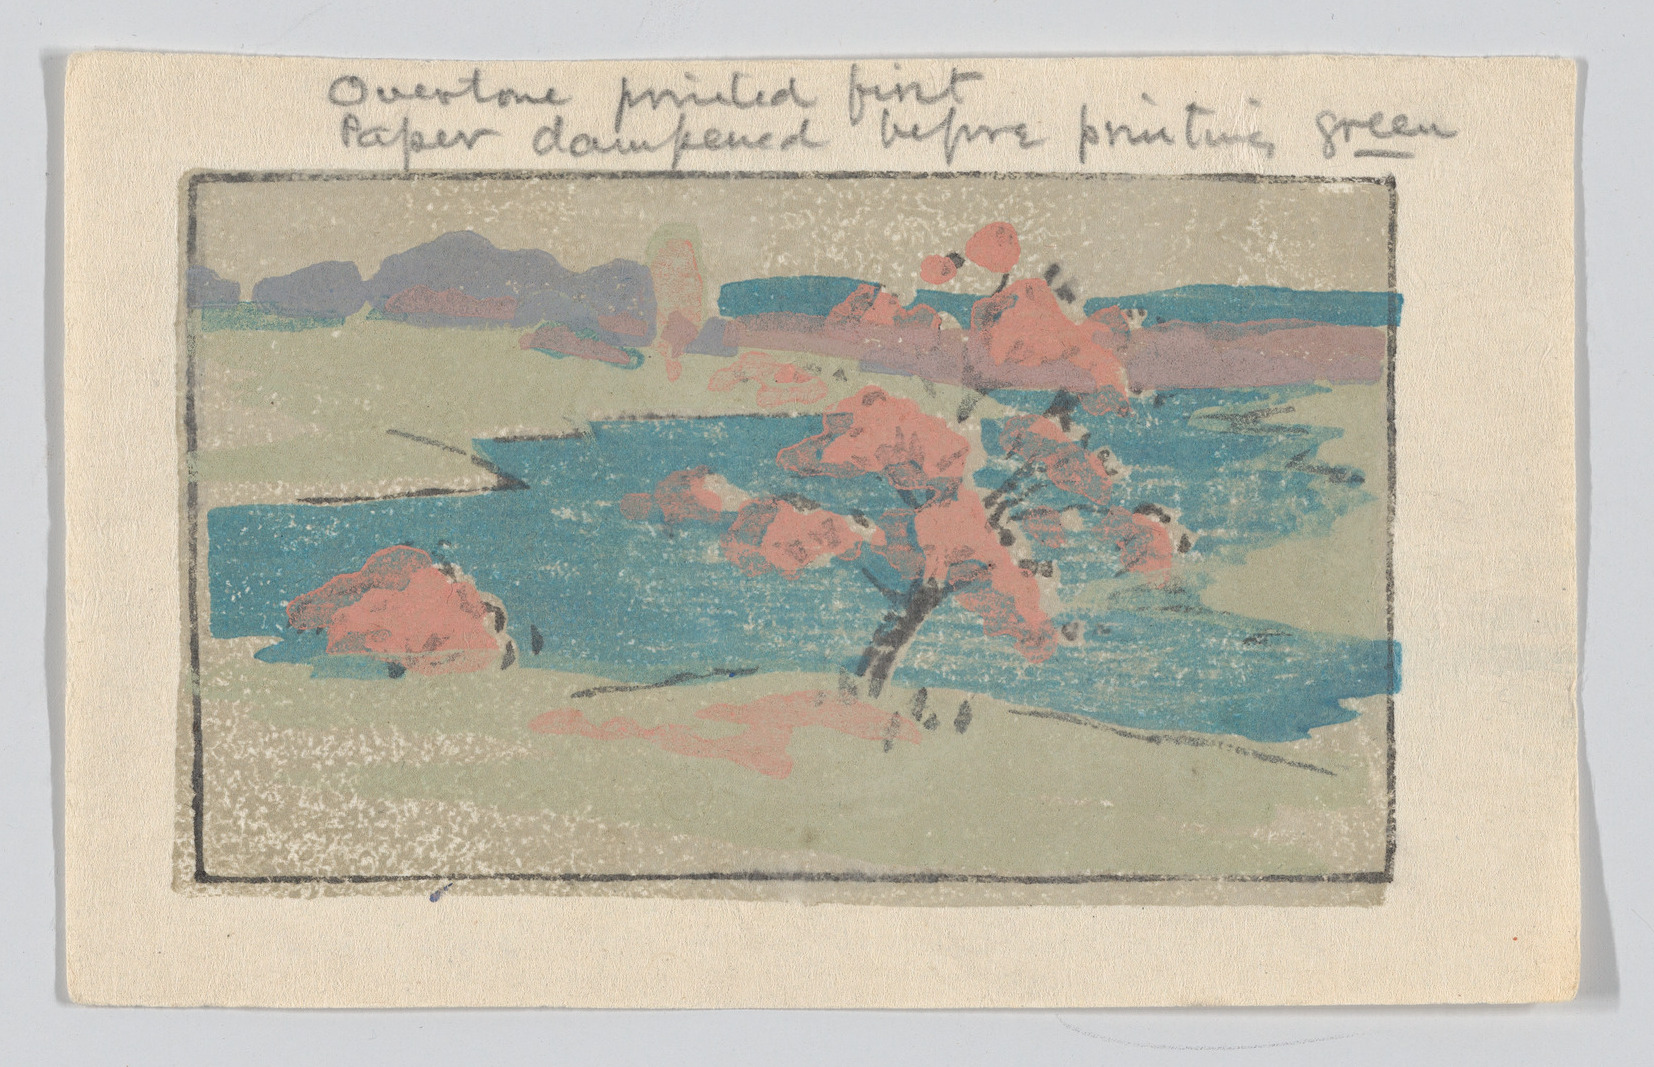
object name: woodcut, print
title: Nabby's Point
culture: american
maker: arthur wesley dow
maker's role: artist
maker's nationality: american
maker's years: 1857-1922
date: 1913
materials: paper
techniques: woodcut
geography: united states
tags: landscapes